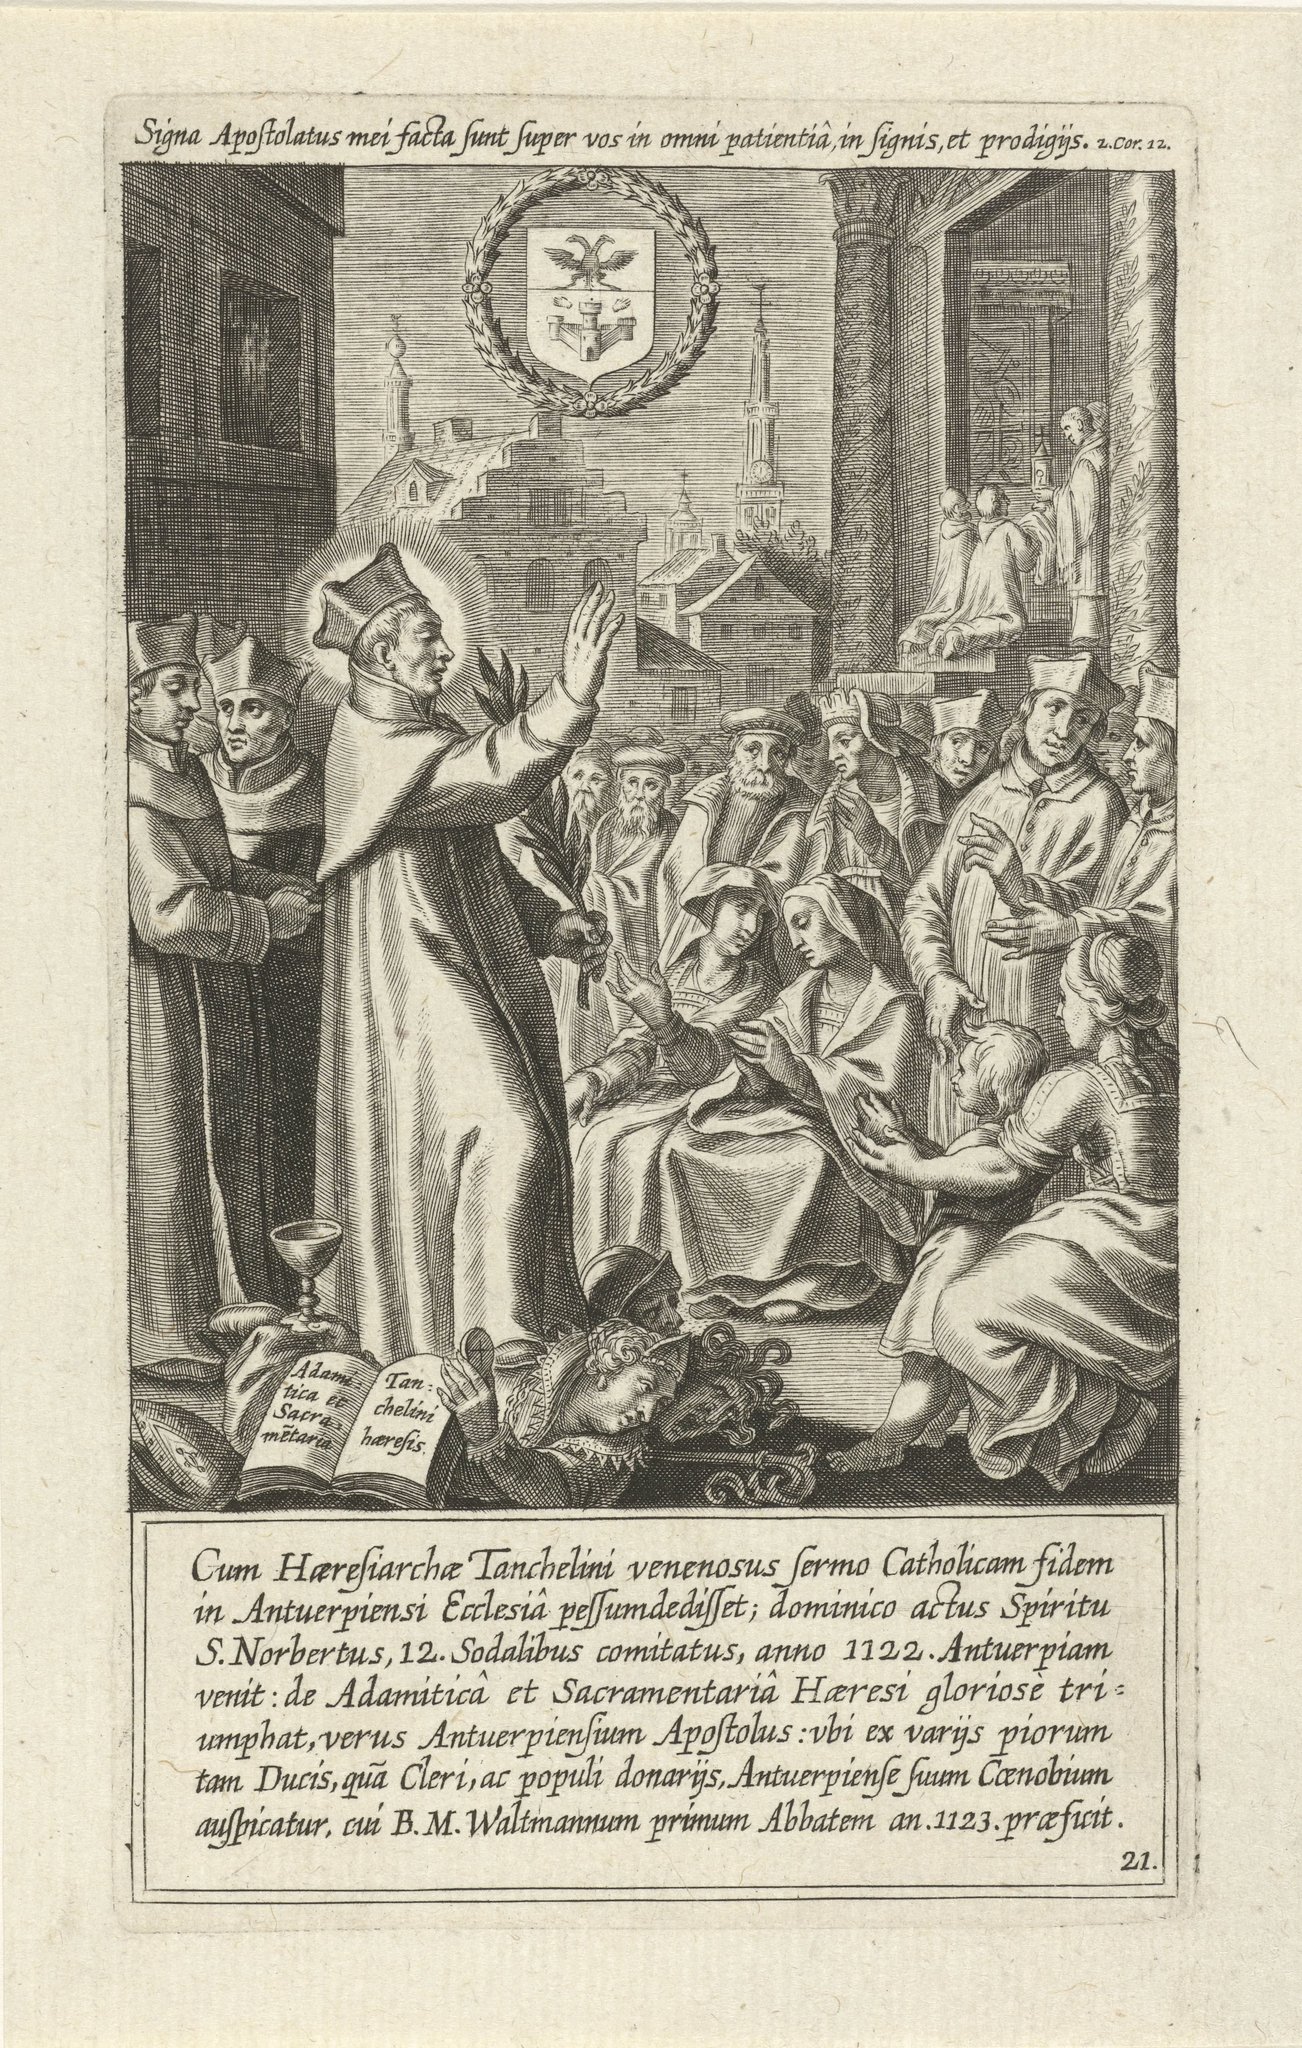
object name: book illustration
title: De heilige Norbertus preekt tegen Tanchelm in Antwerpen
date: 1622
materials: paper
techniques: engraving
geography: antwerp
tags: st. norbert preaching at antwerp before the dissenter tankelin, antwerp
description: De heilige Norbertus wordt naar Antwerpen gestuurd waar hij preekt tegen de ketterse leer van de monnik Tanchelm. Norbertus vertrapt leden van de sekte van Tanchelm. Bovenaan het wapenschild van Antwerpen.De prent heeft twee Latijnse opschriften: een boven en een onder de voorstelling.